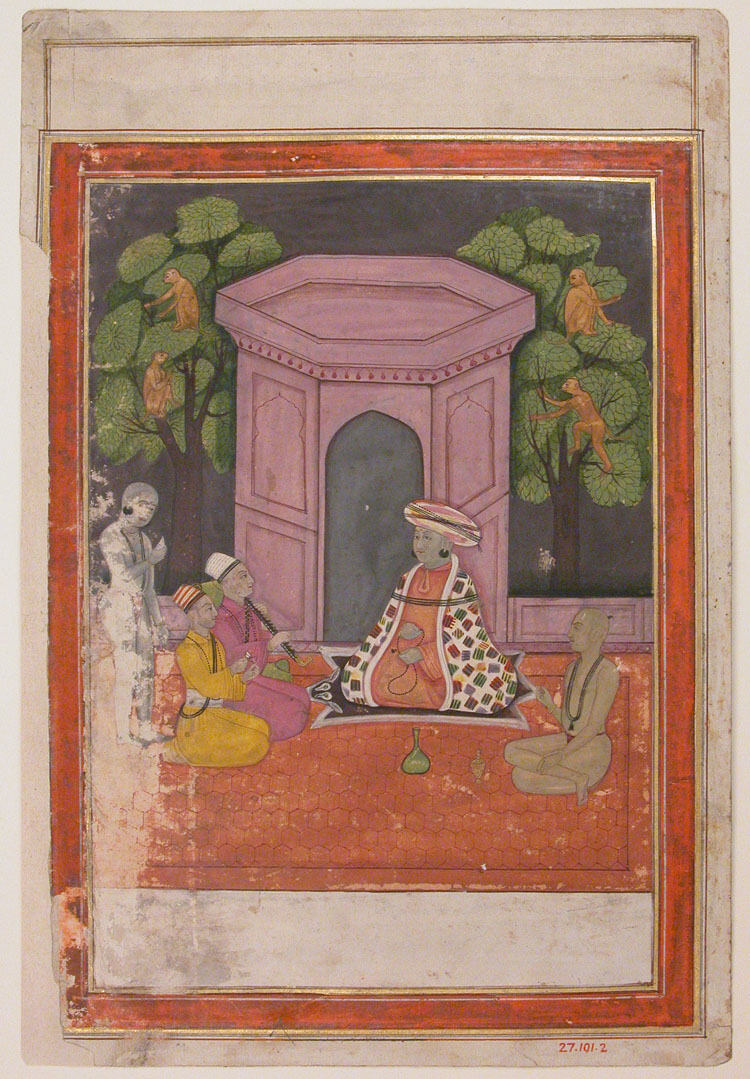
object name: illustrated album leaf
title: Hindu Saint with Two Disciples and Two Musicians on a Rooftop in the Evening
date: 1701-1800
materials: paper, watercolor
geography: india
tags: musical instruments,roofs,men,evening,saints,musicians